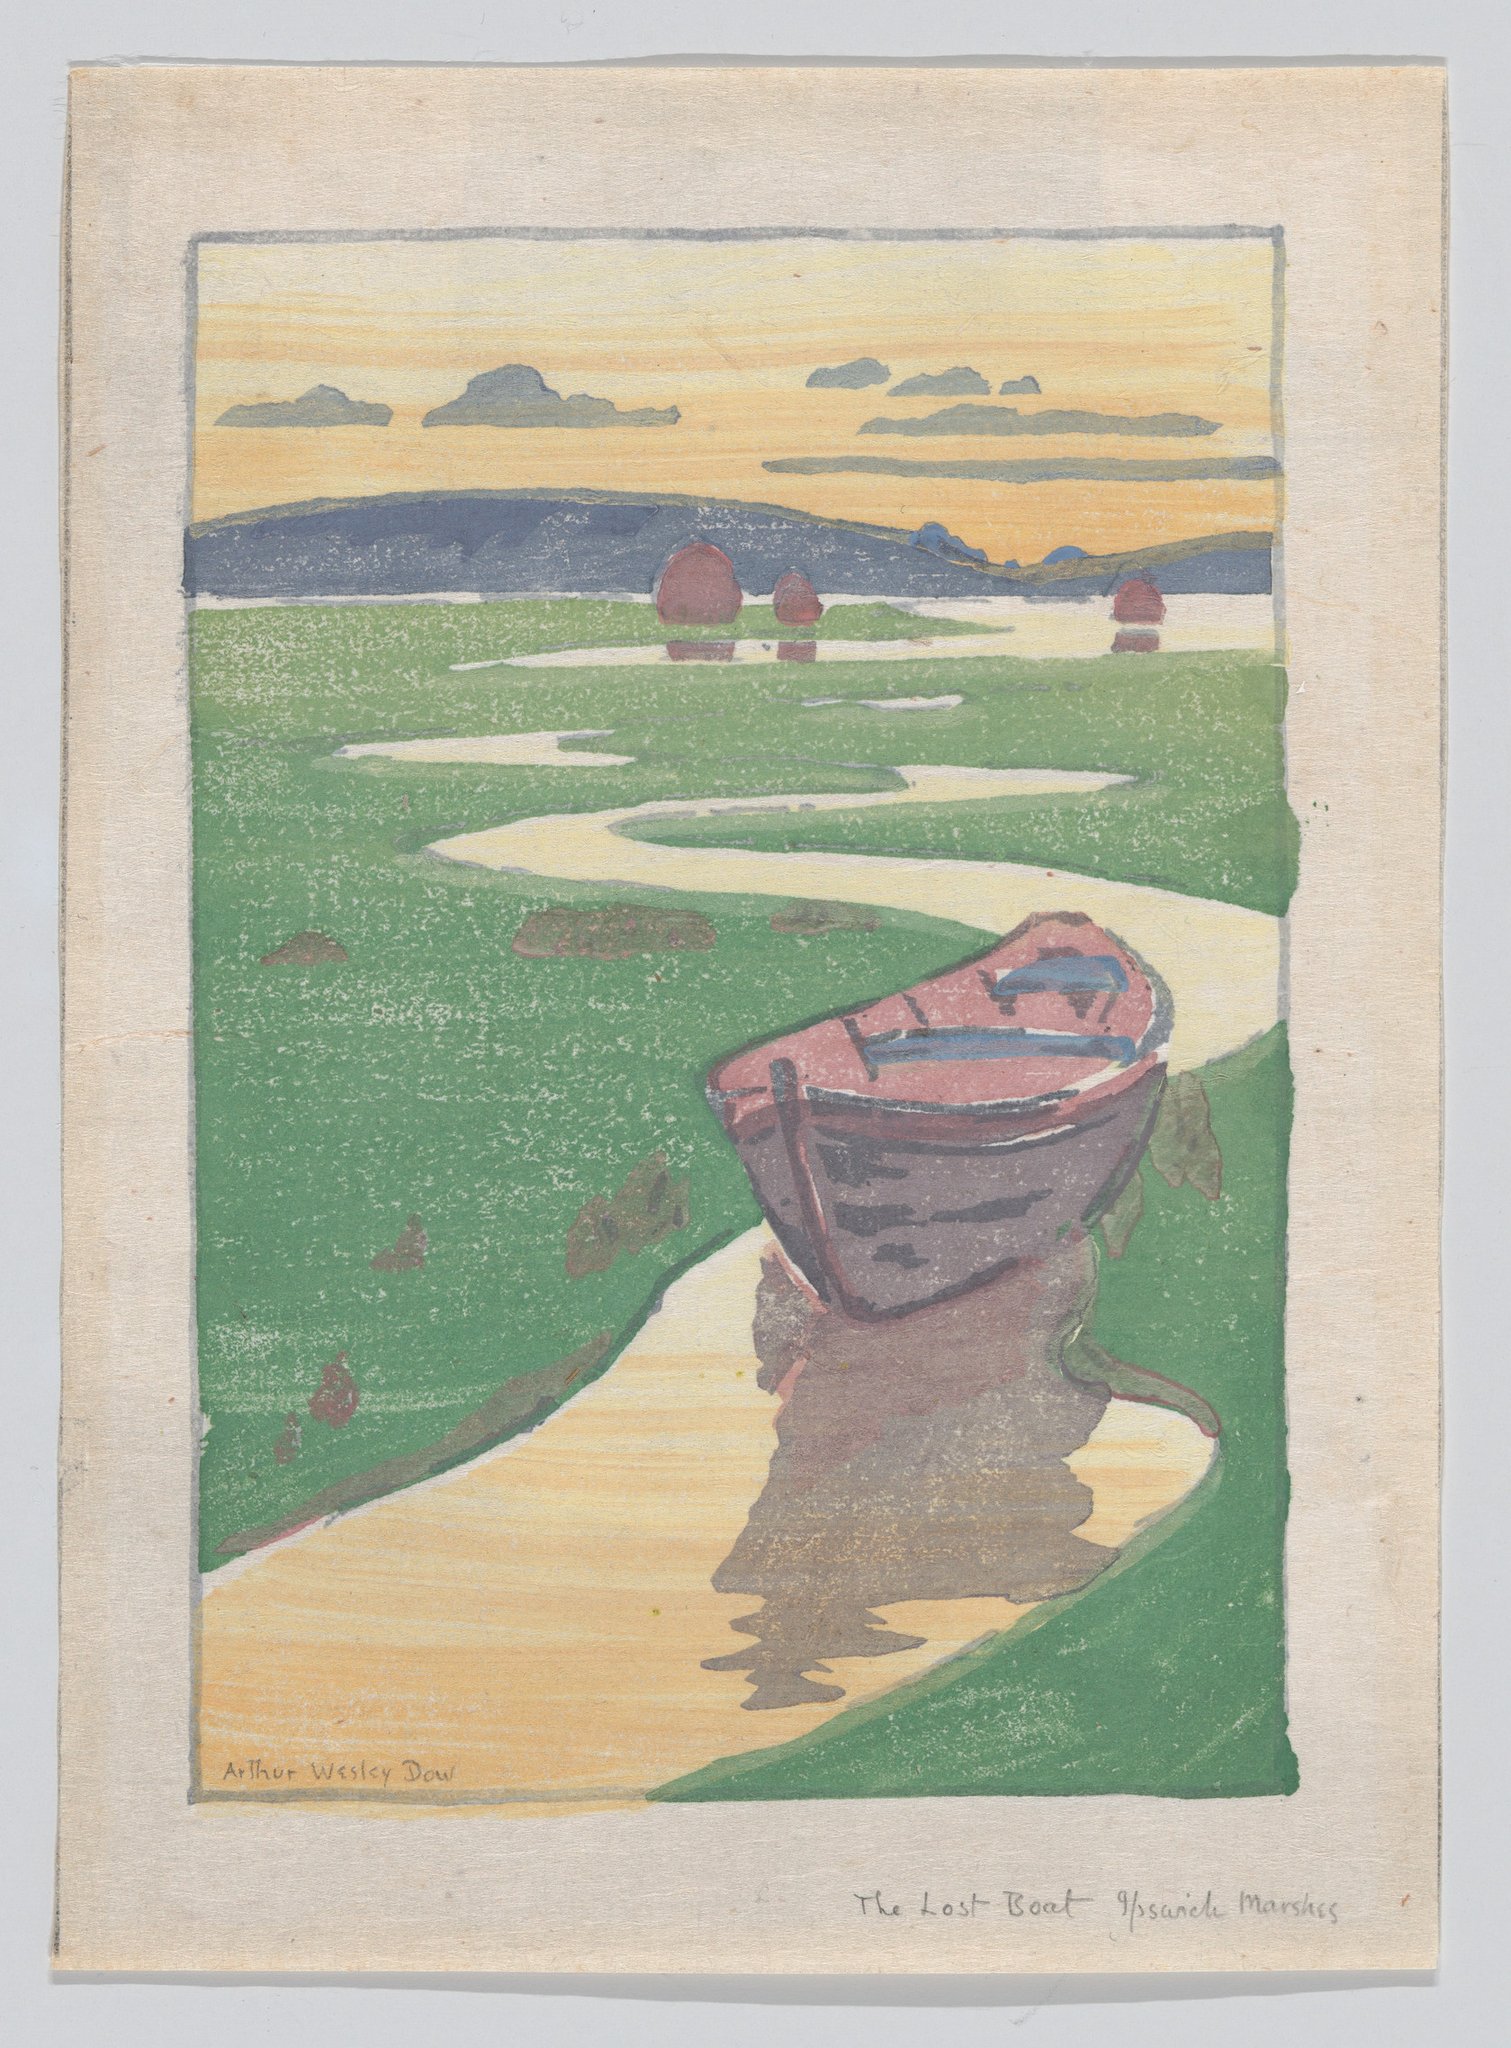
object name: woodcut, print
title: "The Derelict" or "The Lost Boat"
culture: american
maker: arthur wesley dow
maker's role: artist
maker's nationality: american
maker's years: 1857-1922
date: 1916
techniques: woodcut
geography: united states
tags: landscapes,boats